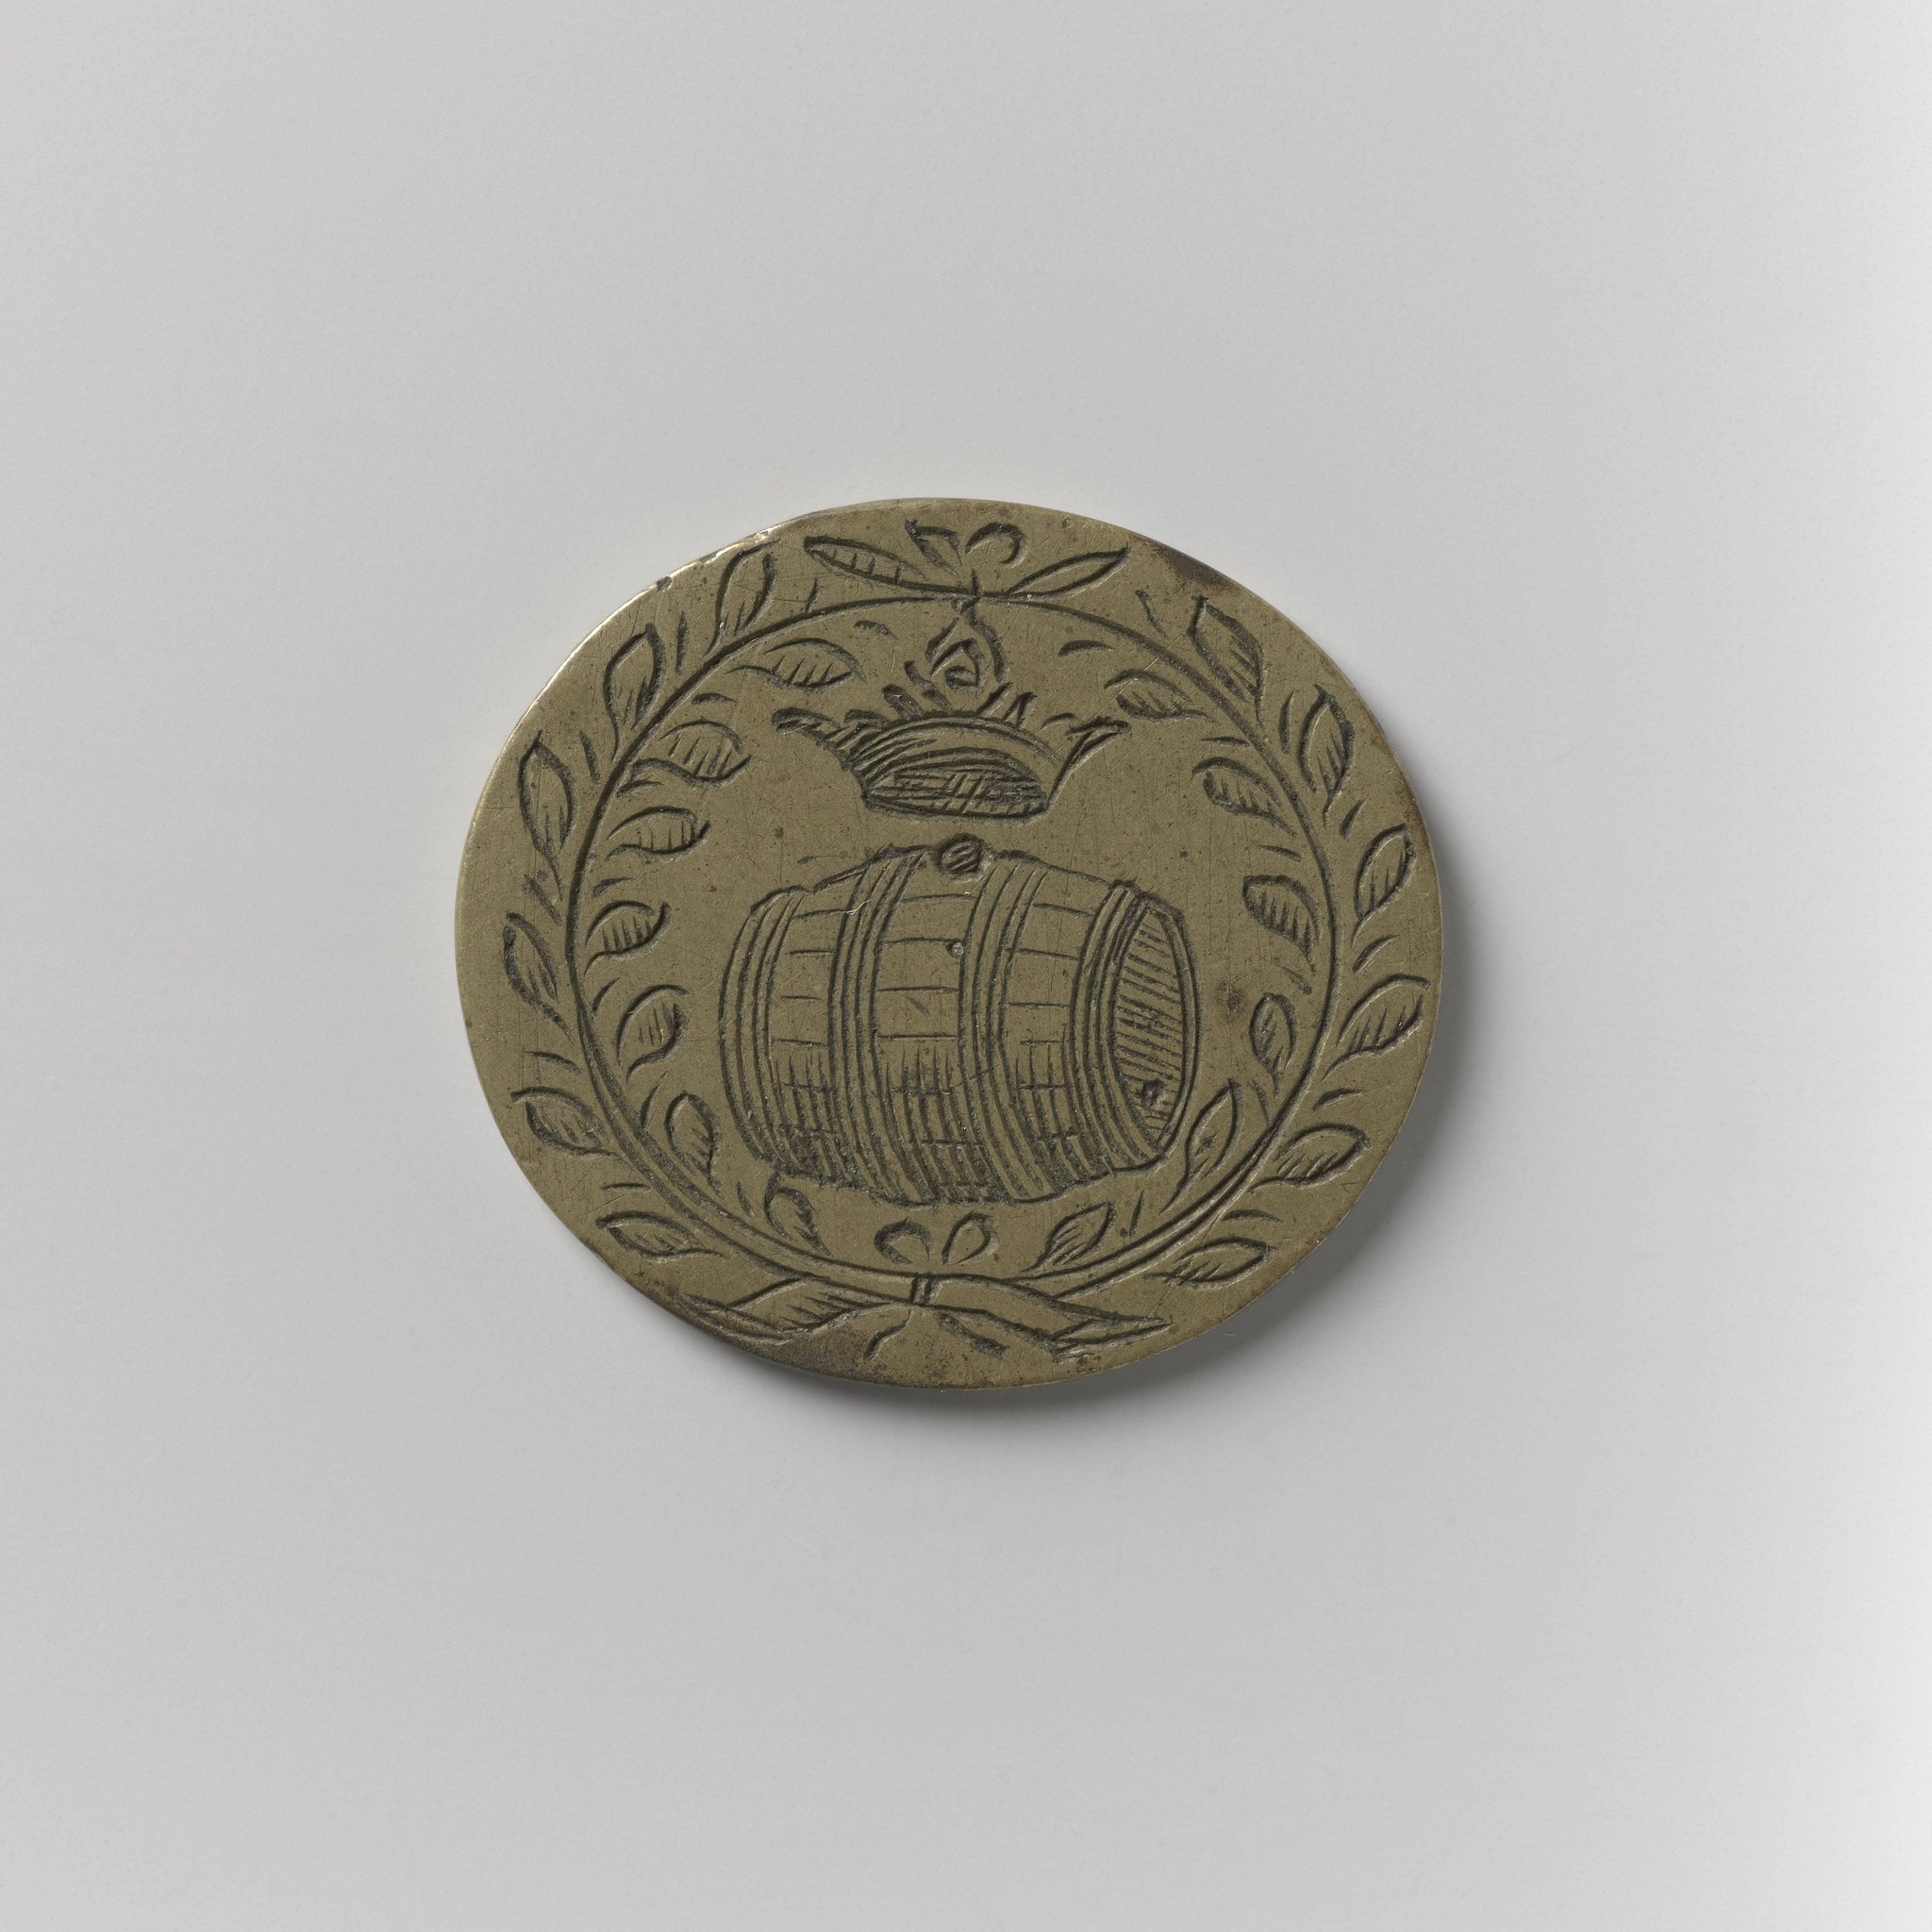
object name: medal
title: Bierbeschooiersgilde van Amsterdam, gildepenning van Jan de Doot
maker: Anonymous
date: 1600-1800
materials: brass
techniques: engraving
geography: amsterdam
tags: amsterdam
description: Messing ovale gildepenning. Voorzijde: gekroond vat binnen bladerkrans. Keerzijde: opschrift binnen bladerkrans.